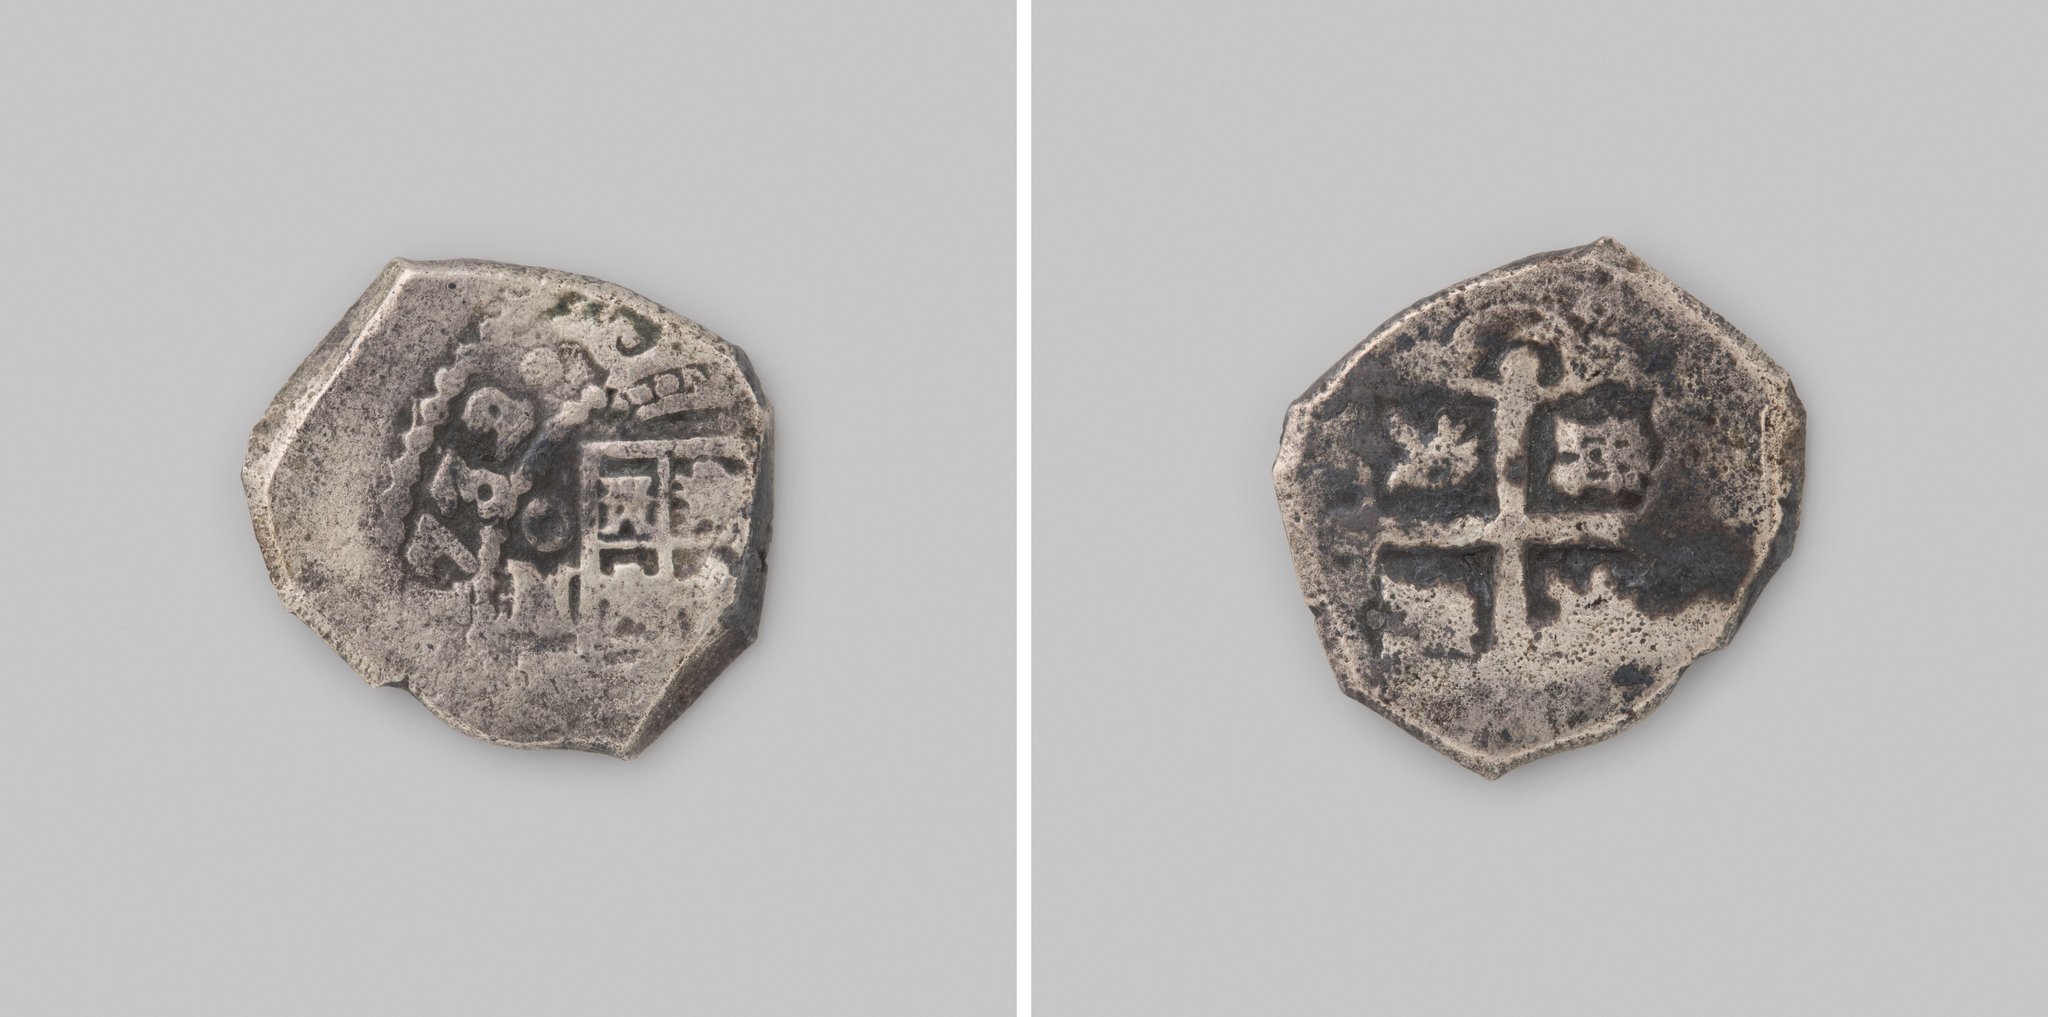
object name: vier reaal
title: Reaal van vieren, geslagen te Mexico, munt uit het wrak van de Oost-Indiëvaarder 't Vliegend Hart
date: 1732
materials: silver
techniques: striking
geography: mexico city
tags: filips v (koning van spanje)